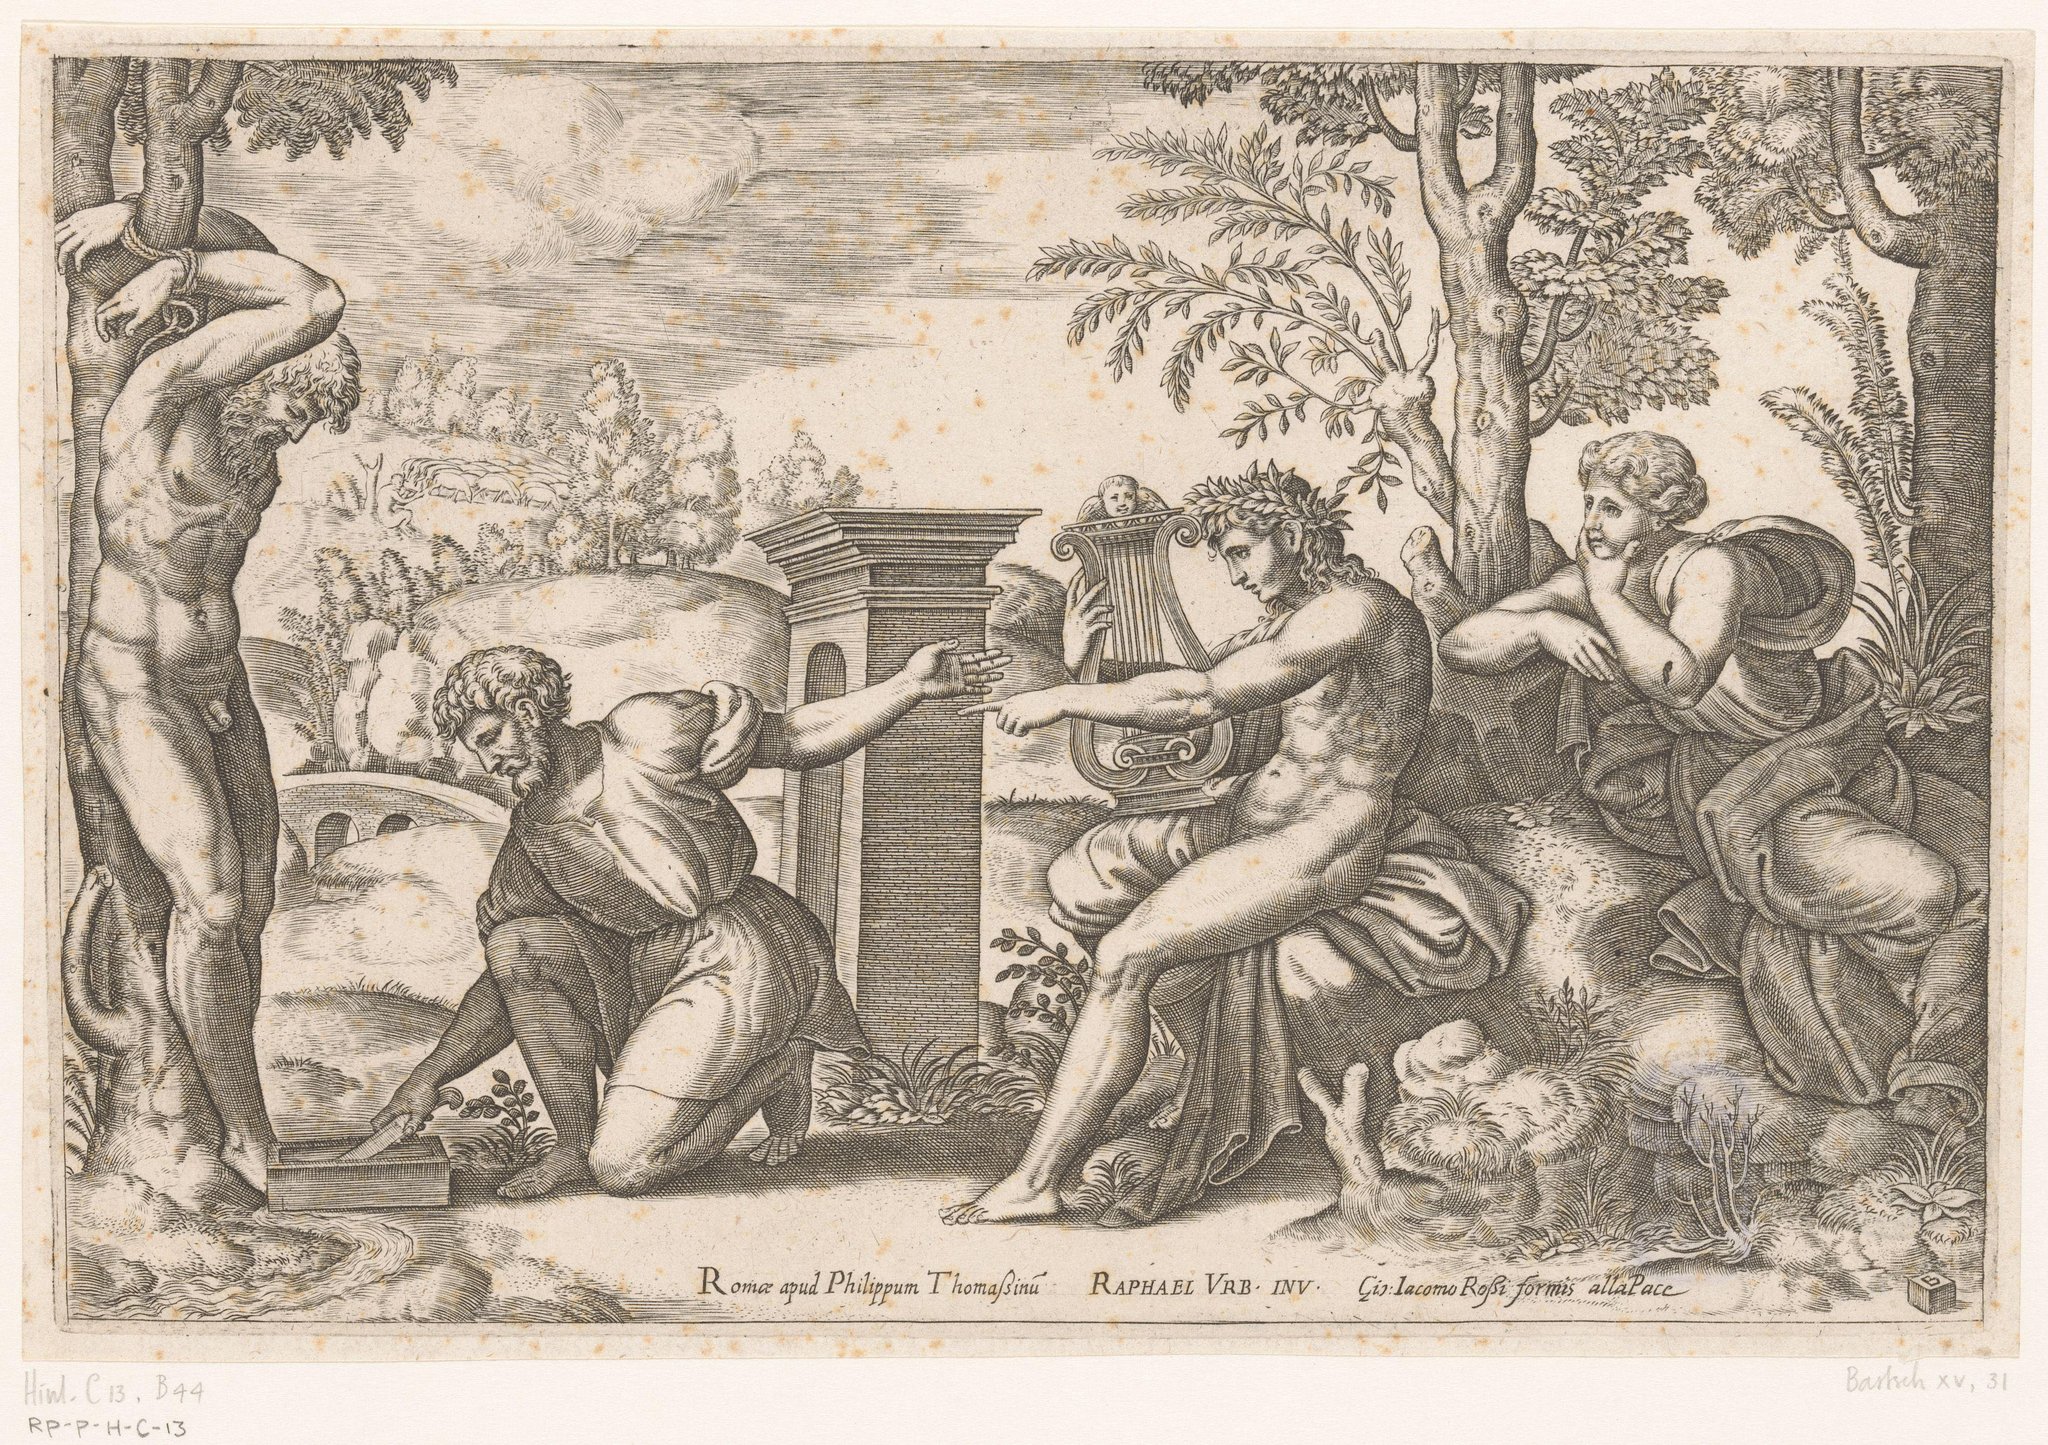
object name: print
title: Apollo en Marsyas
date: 1530-1560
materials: paper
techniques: engraving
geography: rome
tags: city-view, and landscape with man-made constructions, punishment of marsyas: he is flayed by apollo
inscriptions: collector's mark: Lugt 10, collector's mark: ‘Hinloopen’, collector's mark: Lugt 11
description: De sater Marsyas is aan een boom gebonden en staat op het punt om gevild te worden. Rechts zit Apollo met zijn lier en een vrouw die toekijkt. Op de achtergrond een landschap.